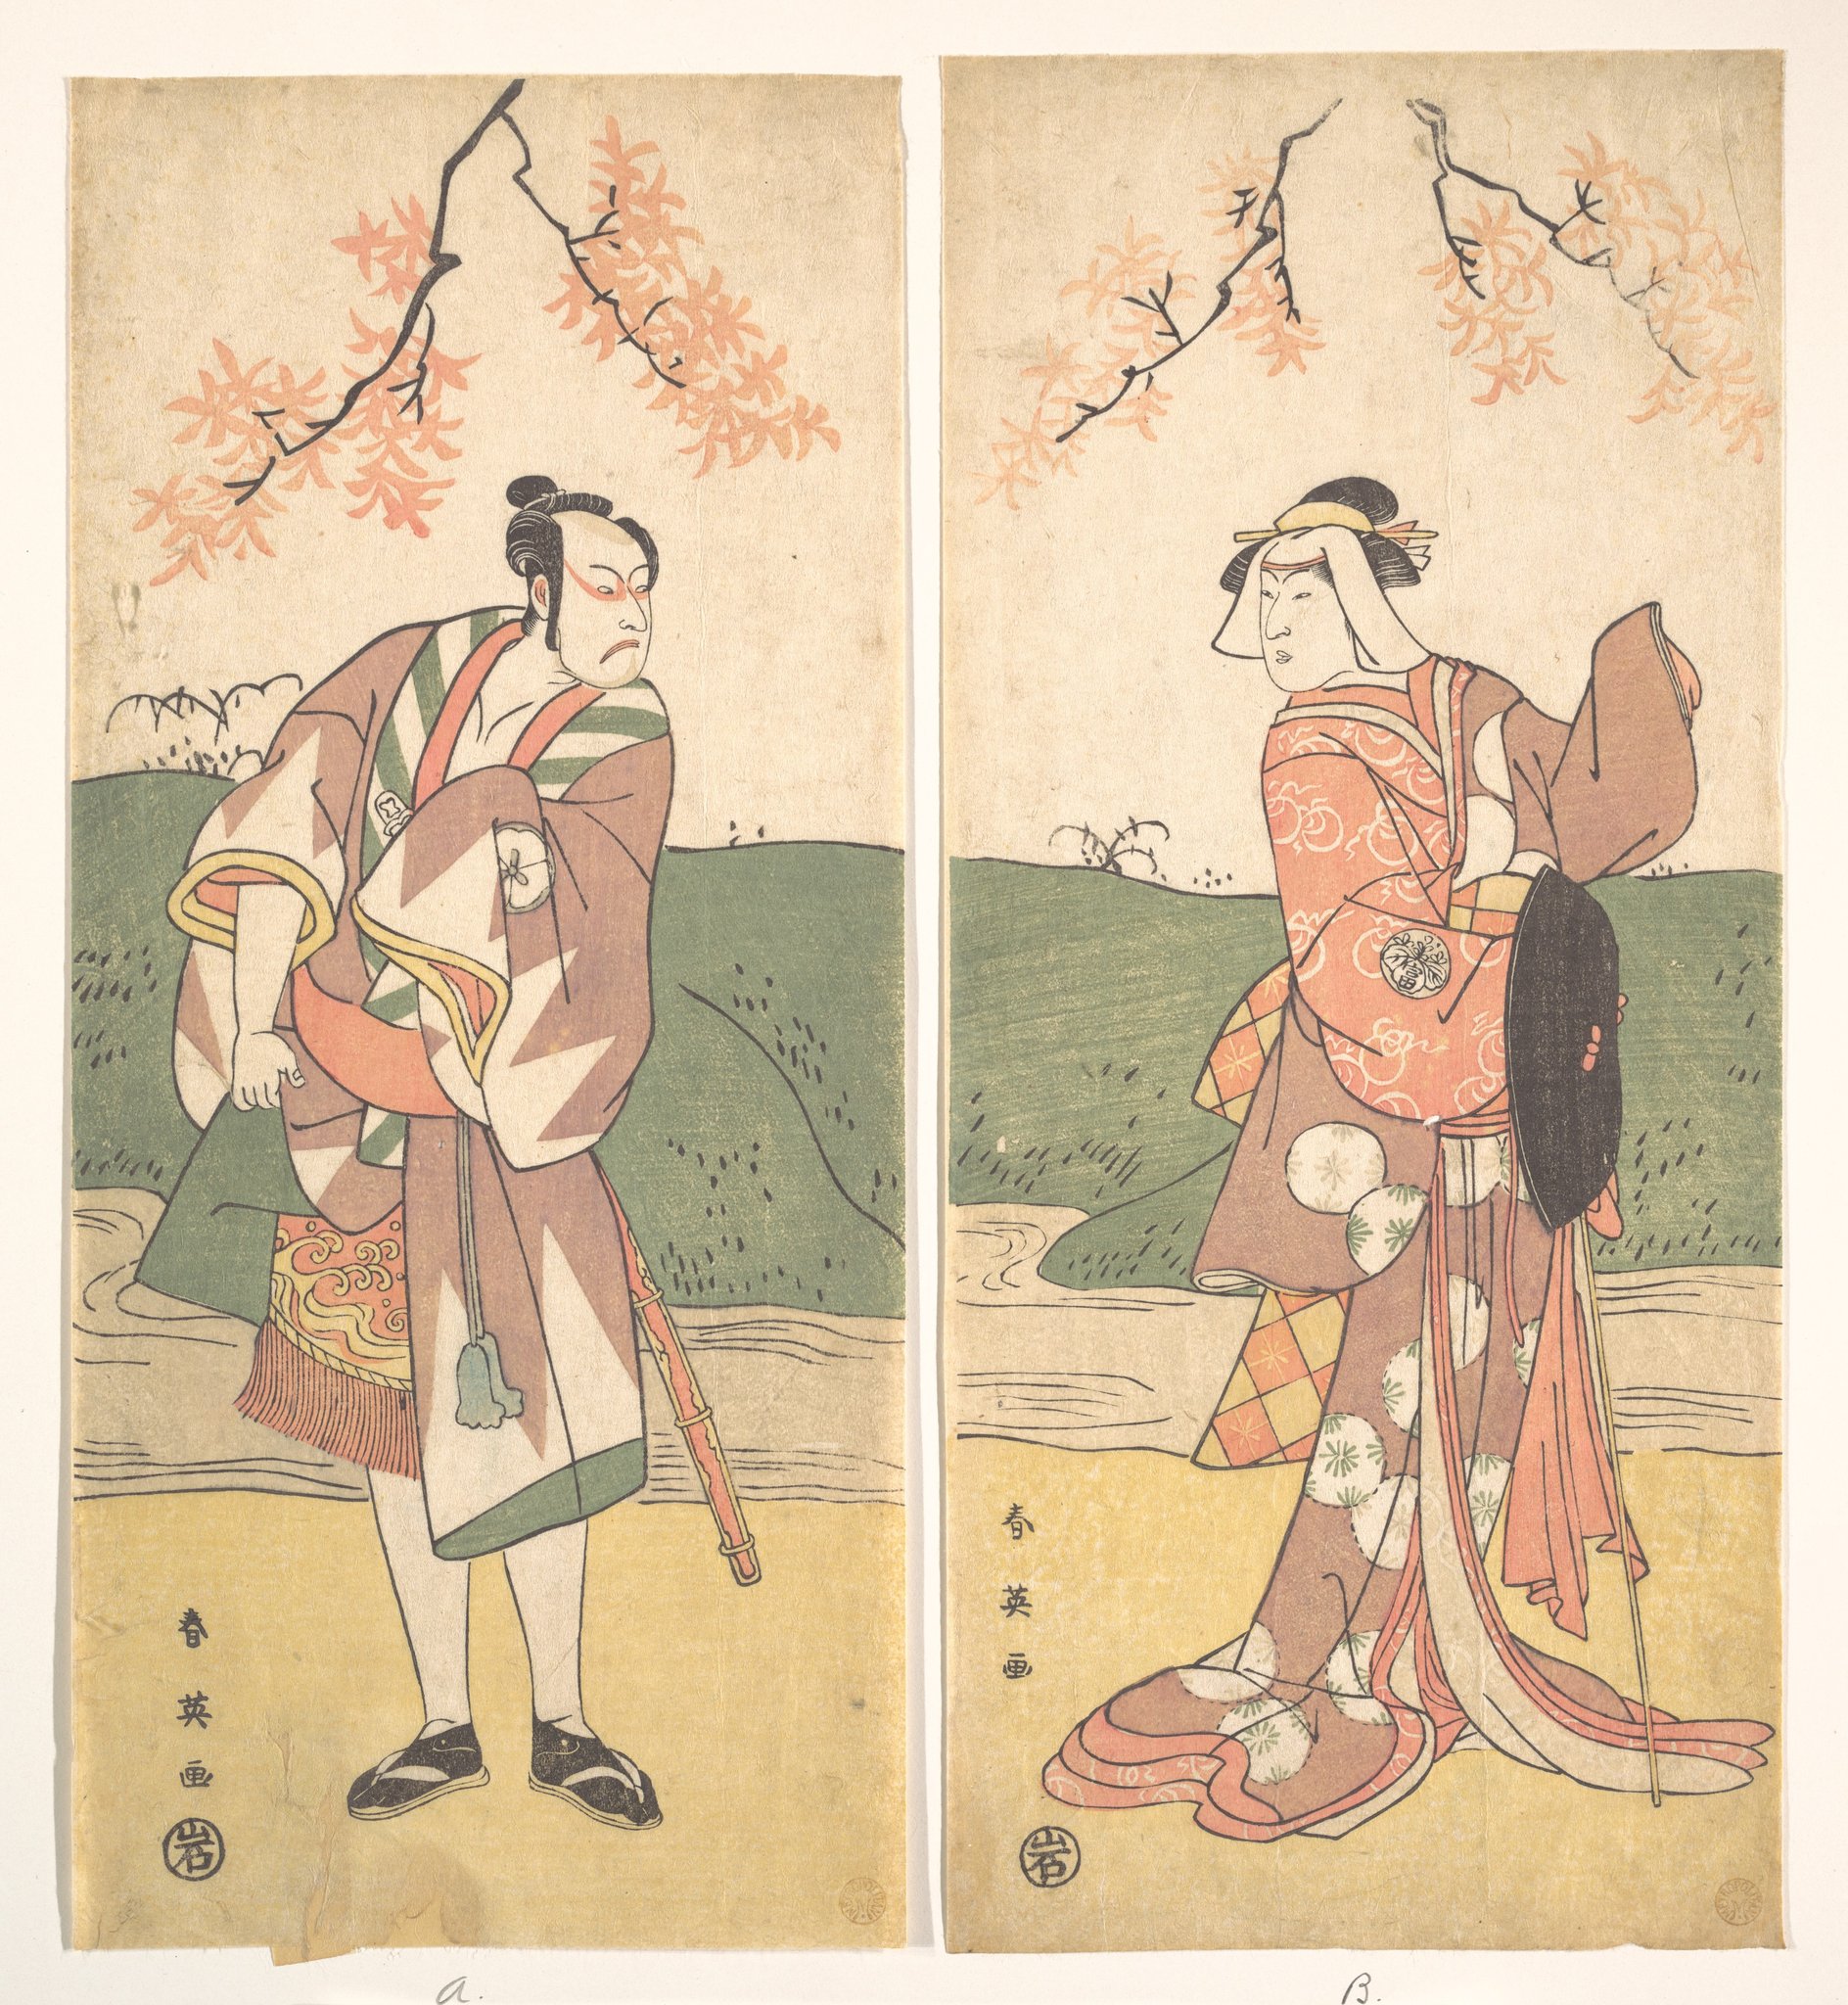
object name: print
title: The Actor Morita Kanya Wearing One Sword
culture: japanese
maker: katsukawa shun'ei 勝川春英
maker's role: artist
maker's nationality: japanese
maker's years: 1762-1819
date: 1792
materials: ink, paper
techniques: woodblock print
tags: swords,actors